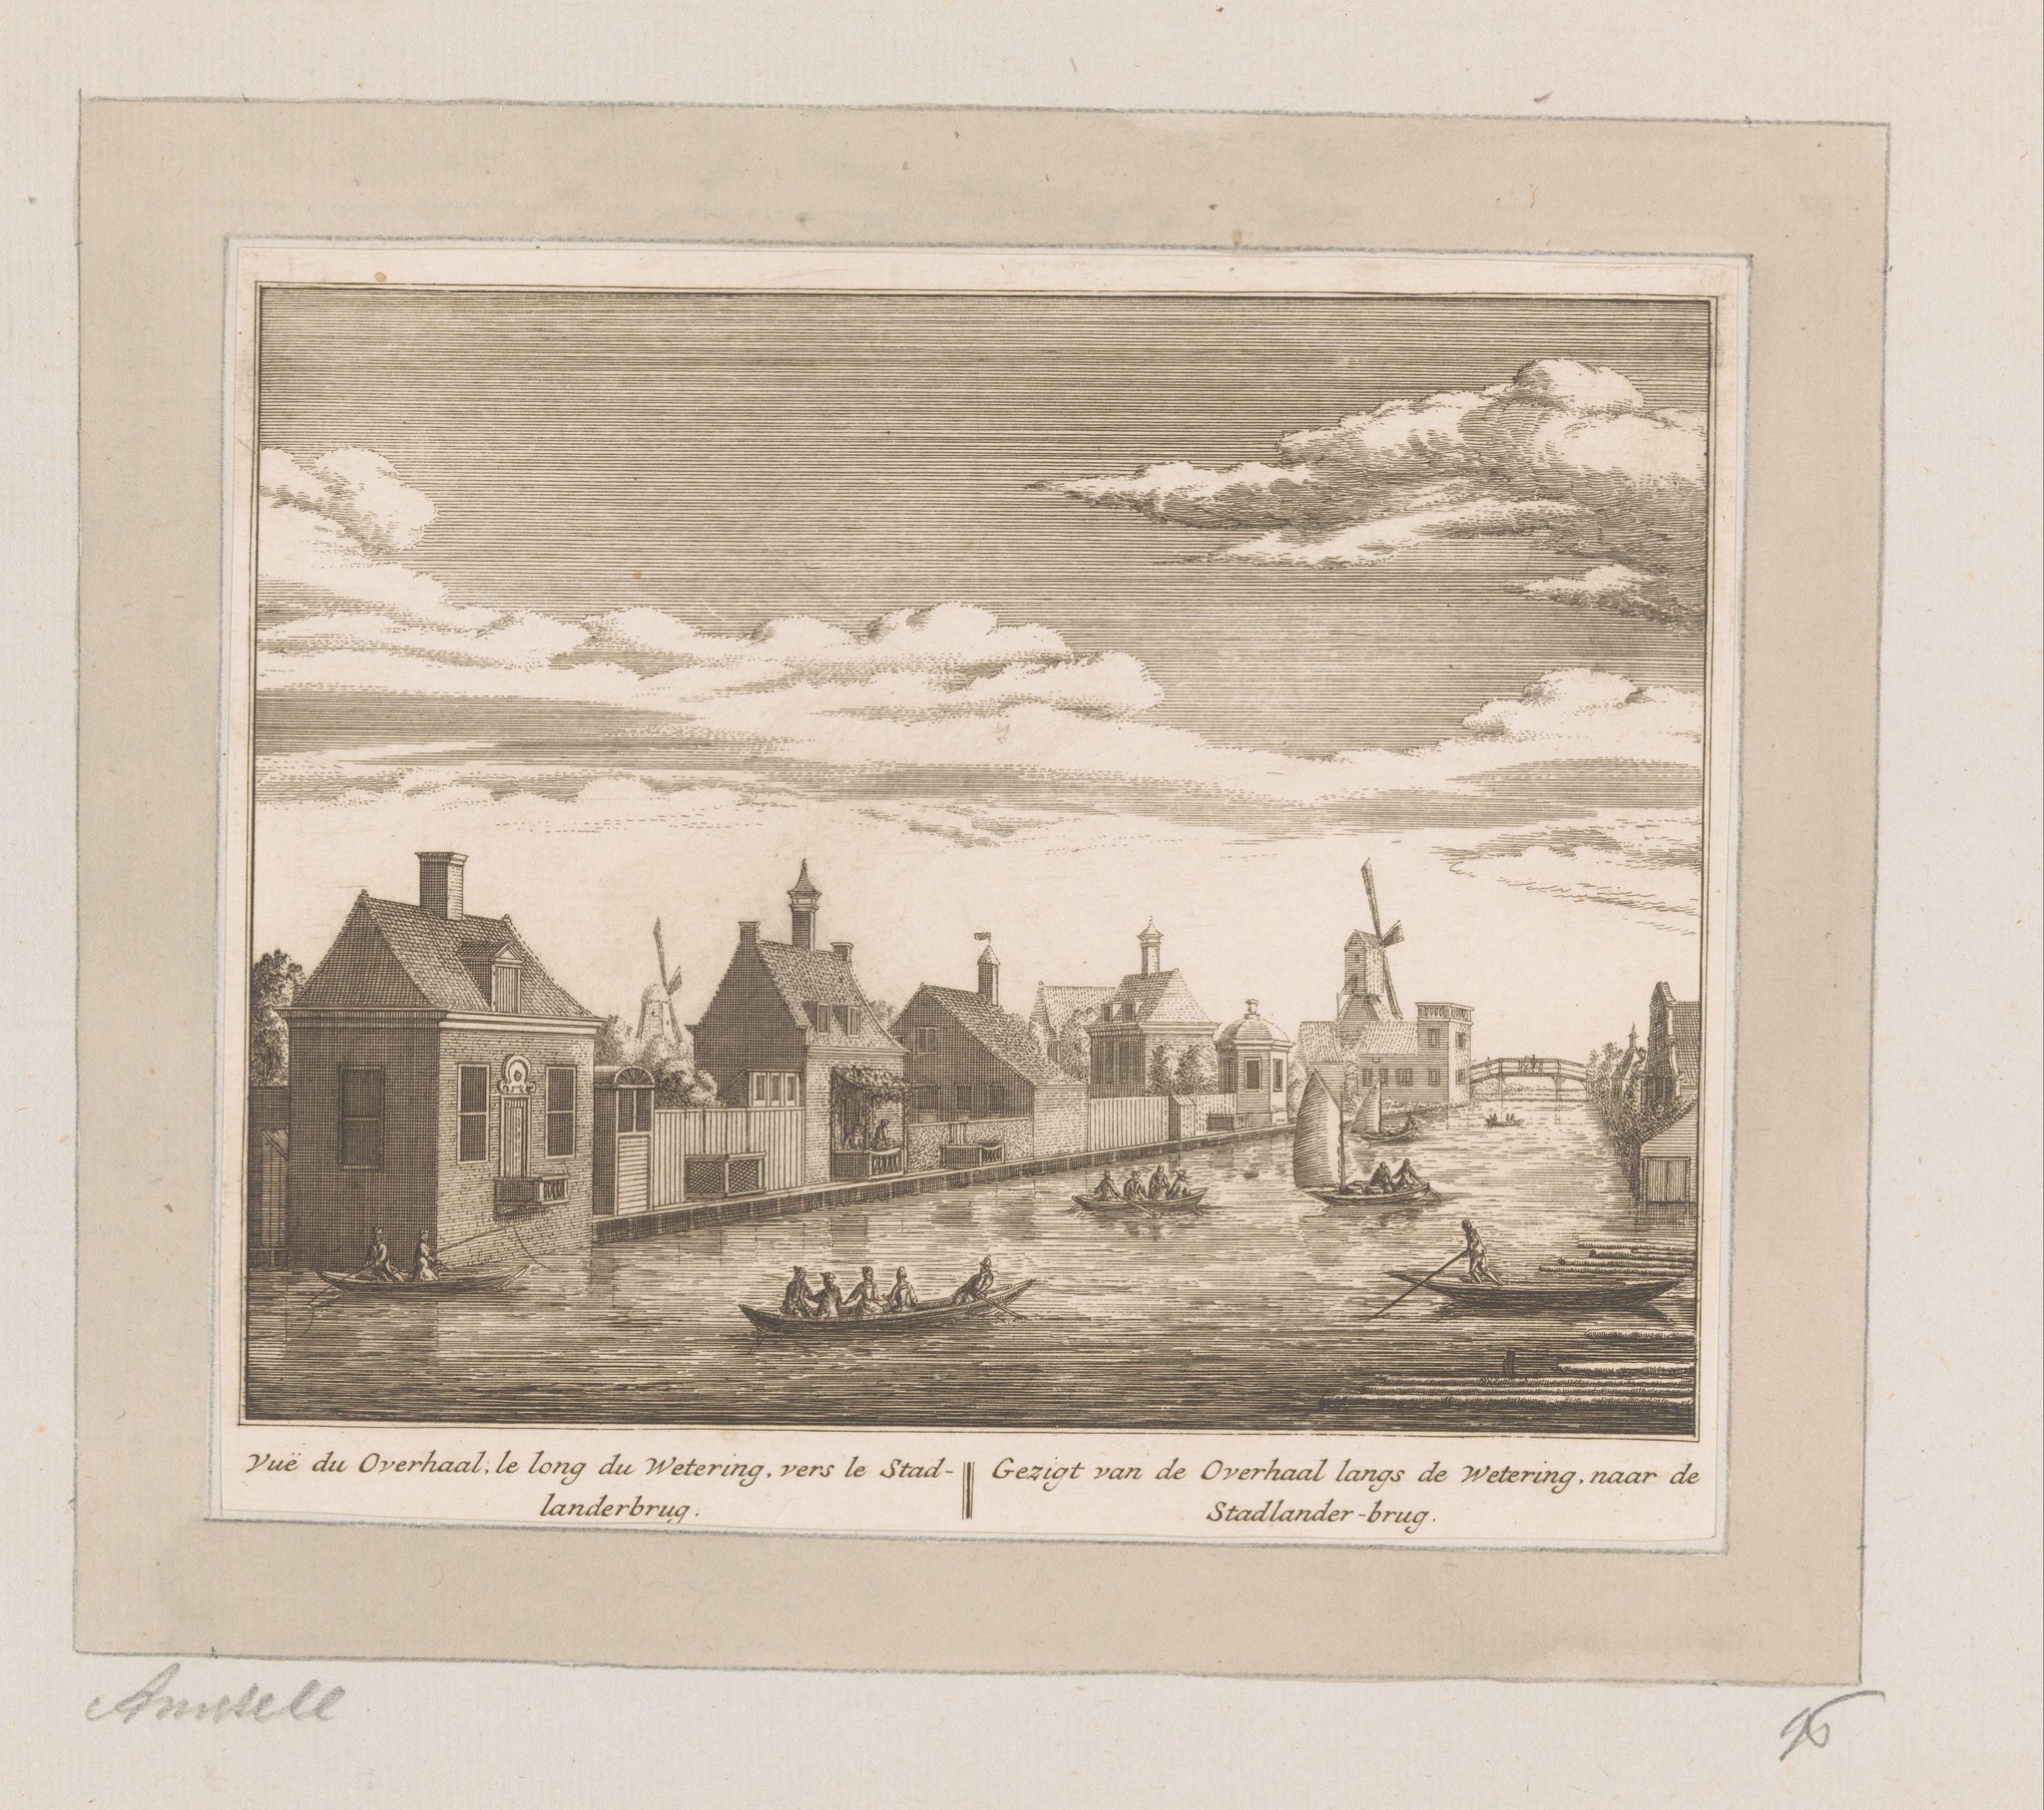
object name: book illustration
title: Gezicht op de wetering richting de Stadlanderbrug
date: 1730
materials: paper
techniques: etching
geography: amsterdam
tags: detached house in city, rowing facing backward, pulling, poling, punting, bridge in city across river, canal, etc., windmill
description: Prent uit: Tijsens, Gijsbert. Hollands Arcadia, of de vermaarde rivier den Amstel (...) naar 't léven getekend en in 't ligt gebgragt door Abraham Rademaker (...). Amsterdam: Leonardus Schenk, 1730.